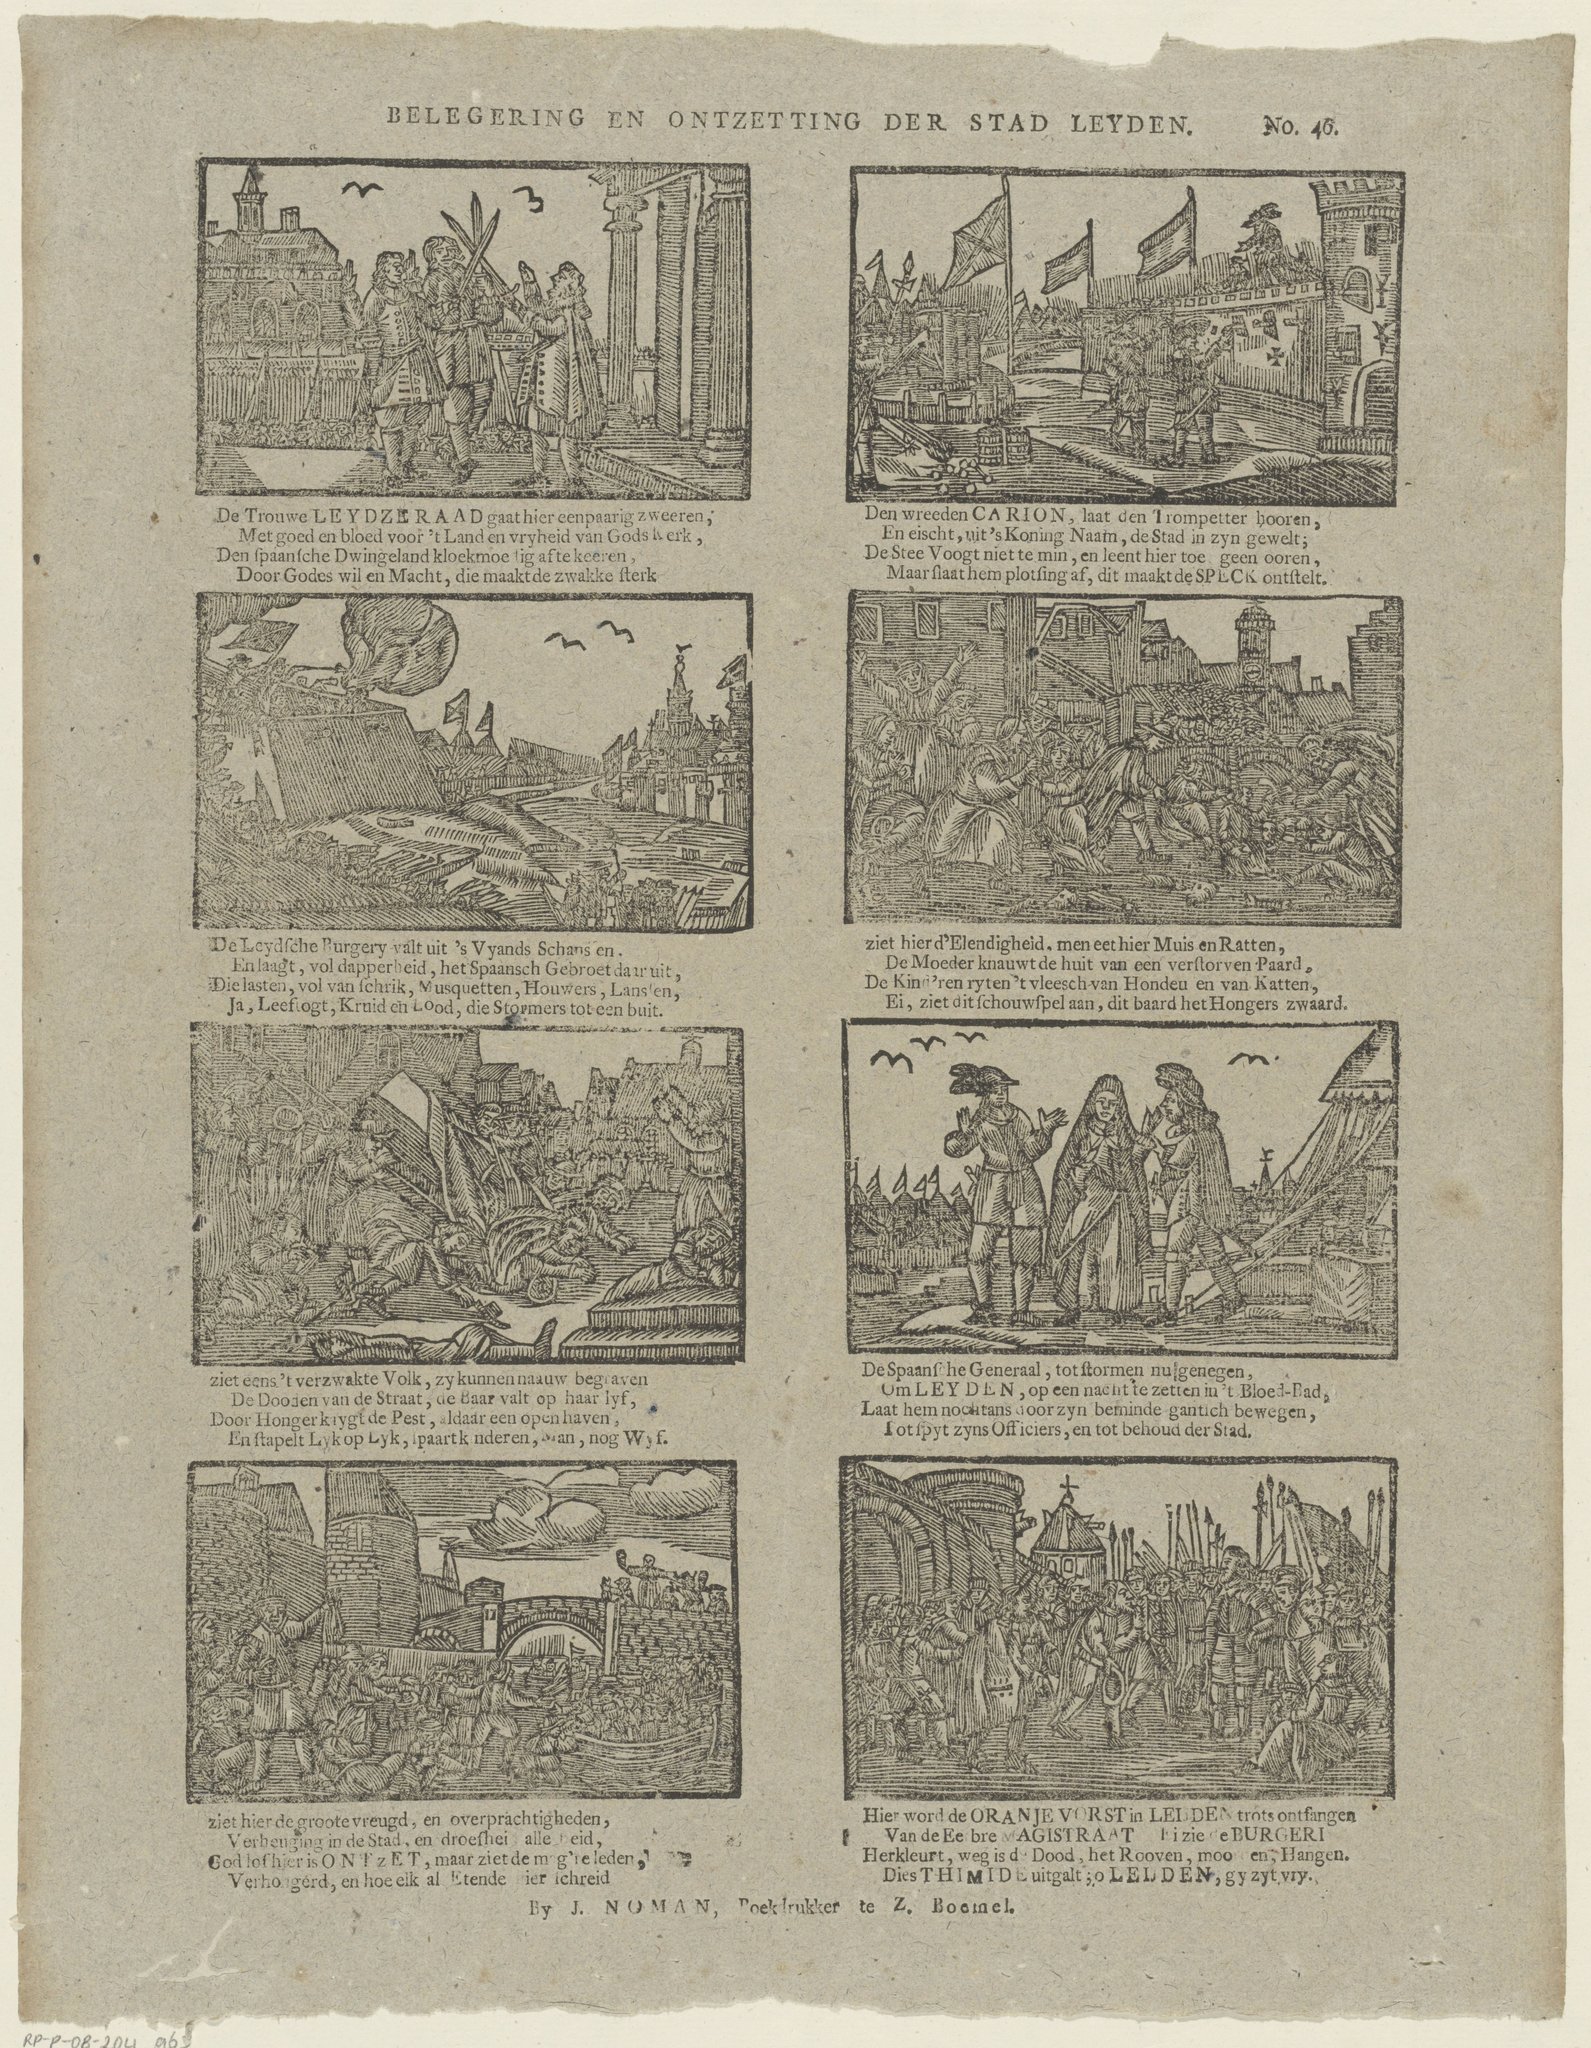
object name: print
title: Belegering en ontzetting der stad Leyden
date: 1806-1830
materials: paper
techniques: letterpress printing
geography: netherlands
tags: history, siege, leiden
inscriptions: collector's mark: Lugt 2760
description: Blad met 8 voorstellingen van het beleg en het ontzet van Leiden. Onder elke afbeelding een vierregelig vers. Genummerd rechtsboven: No. 46.